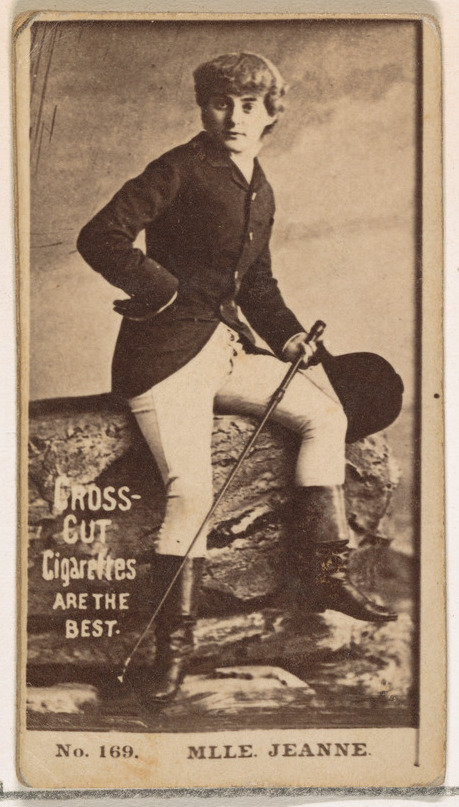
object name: print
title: Card Number 169, Mlle. Jeanne, from the Actors and Actresses series (N145-2) issued by Duke Sons & Co. to promote Cross Cut Cigarettes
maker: w. duke, sons & co.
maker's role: publisher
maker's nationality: american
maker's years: 1870-1920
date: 1880-1889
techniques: albumen silver print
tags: portraits,women,actresses